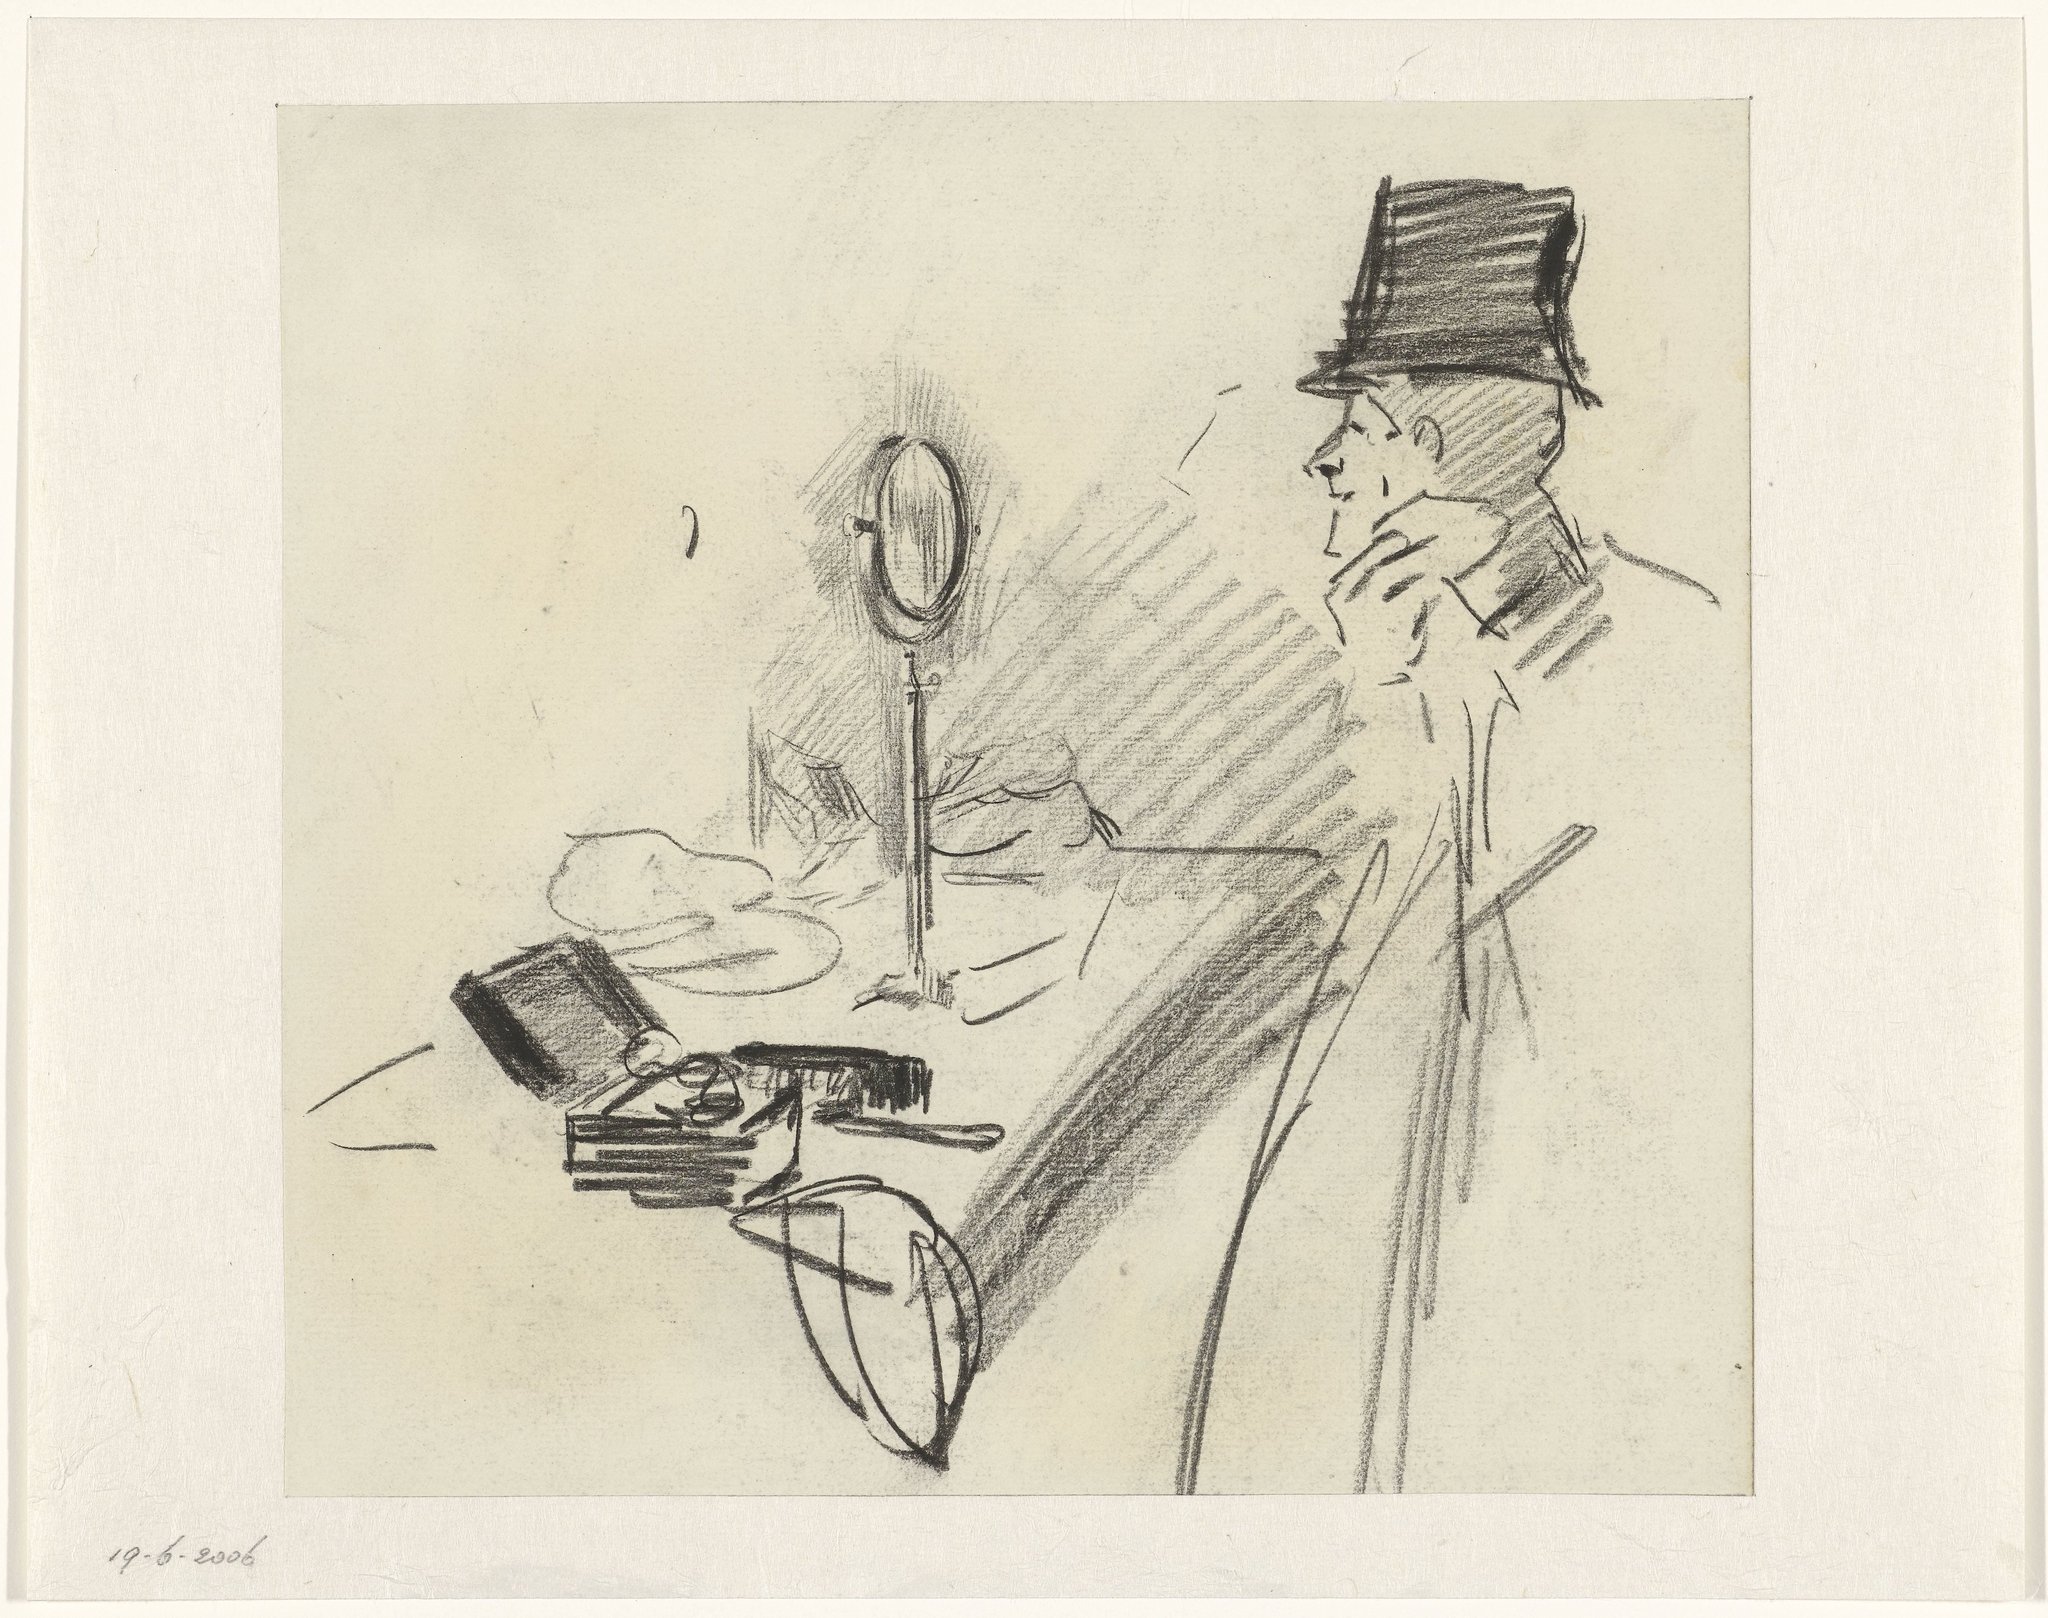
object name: drawing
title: Toneelspeler die zich voor een spiegel schminkt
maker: isaac israels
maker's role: draughtsman, painter, print maker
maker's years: 1865-1934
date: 1905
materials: chalk, paper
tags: actor (on the stage), making up